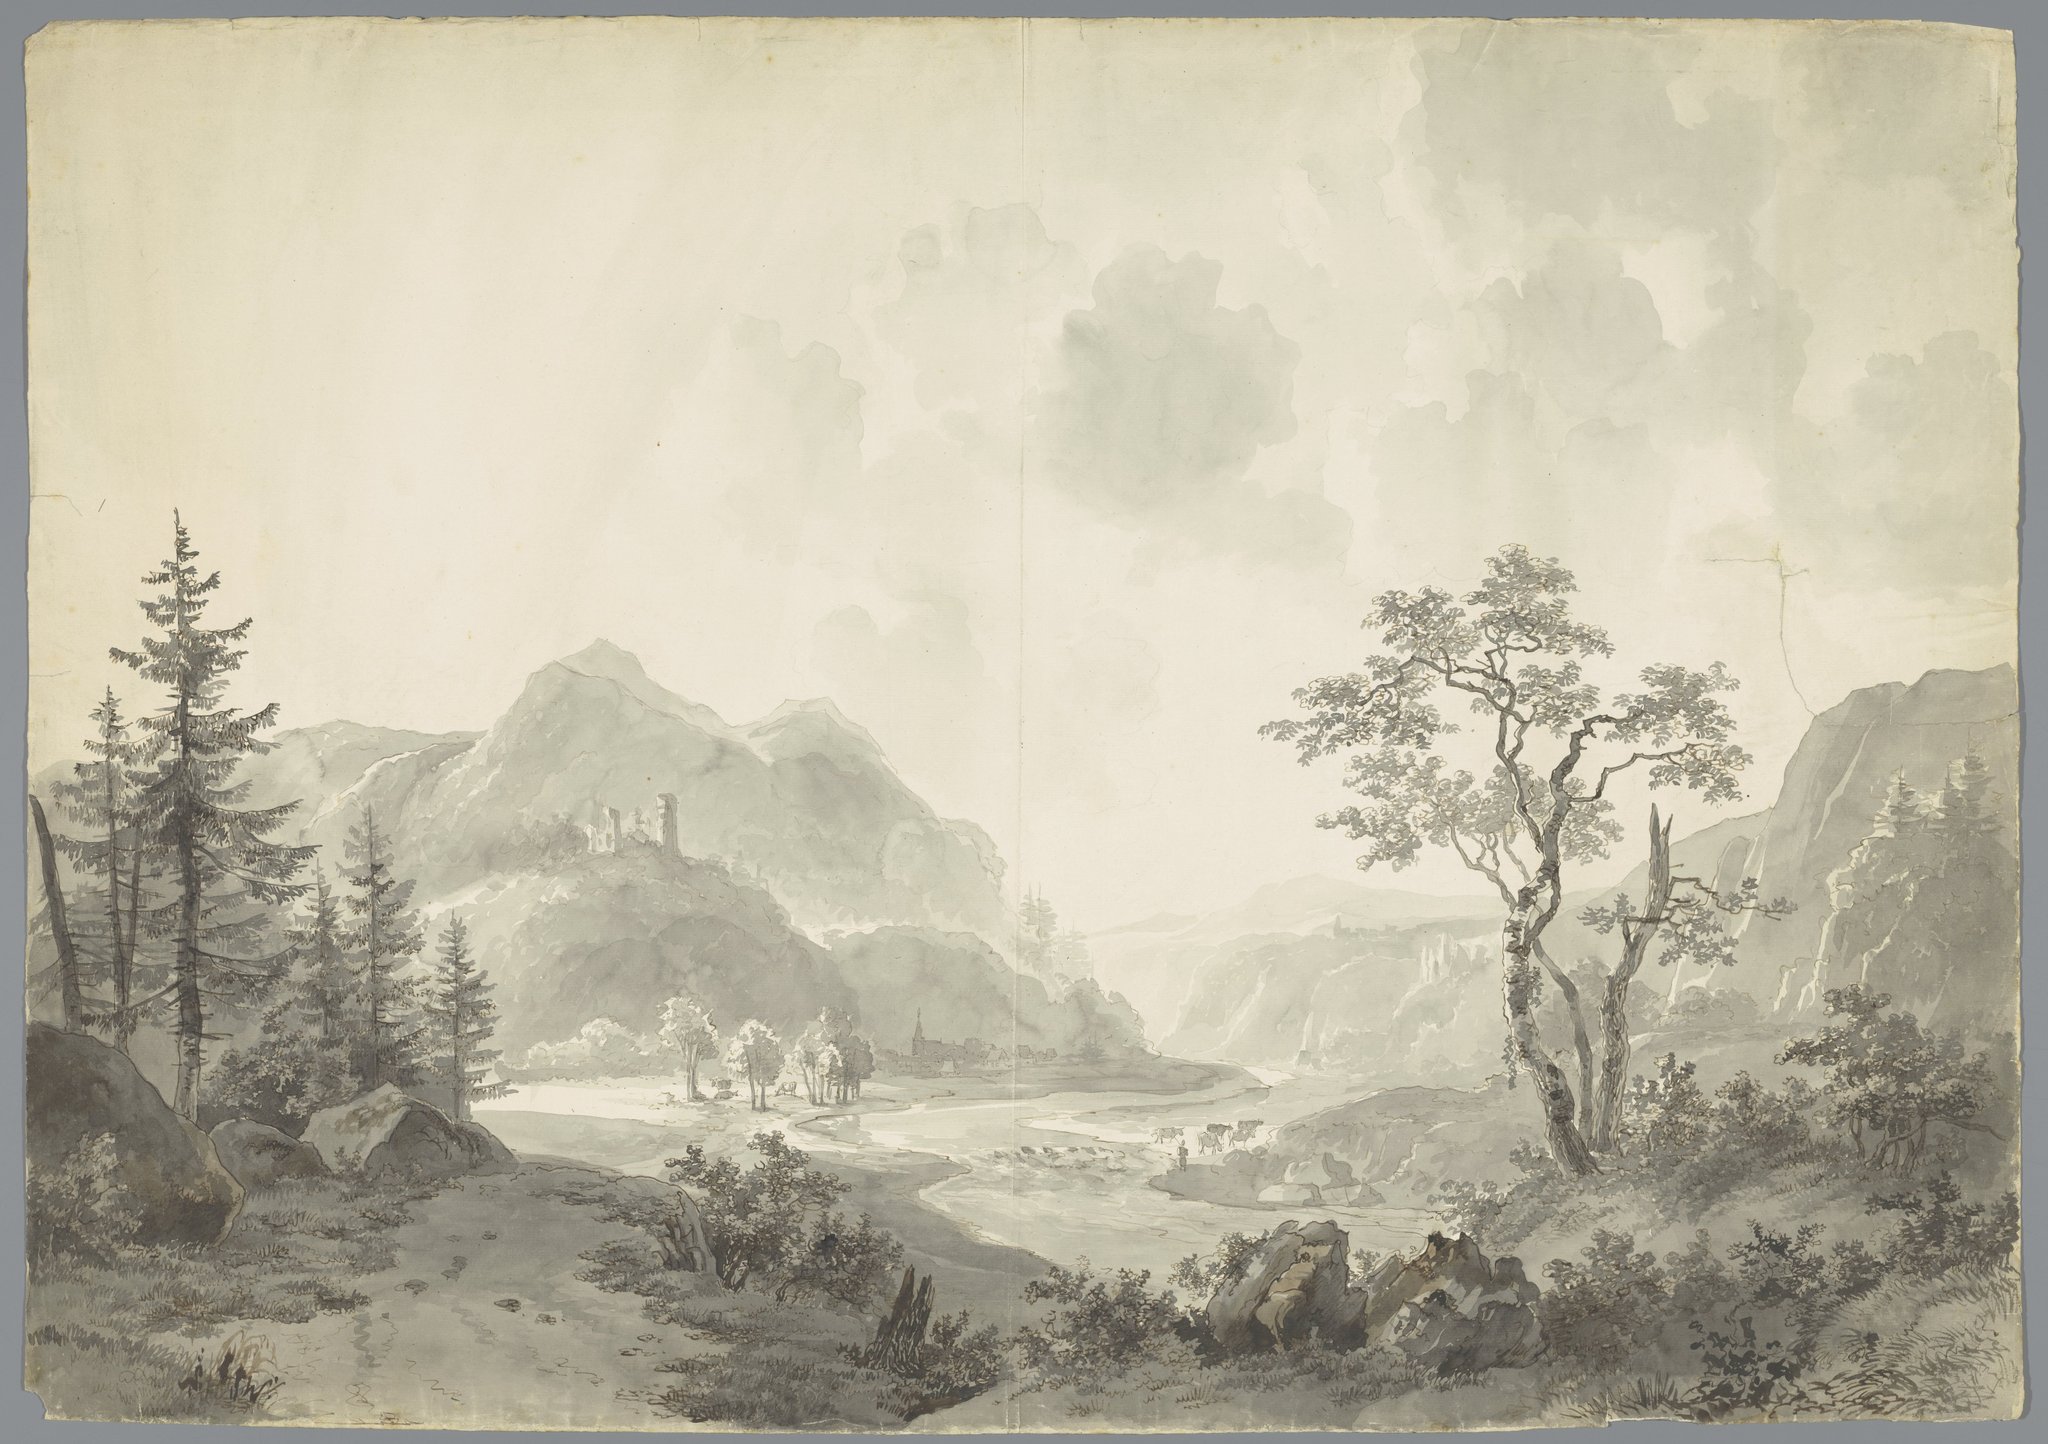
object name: drawing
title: Berglandschap met een rivier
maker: jacob van strij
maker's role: draughtsman, painter, print maker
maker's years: 1756-1815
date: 1766-1815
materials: ink, paper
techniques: brush, pen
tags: river, mountains